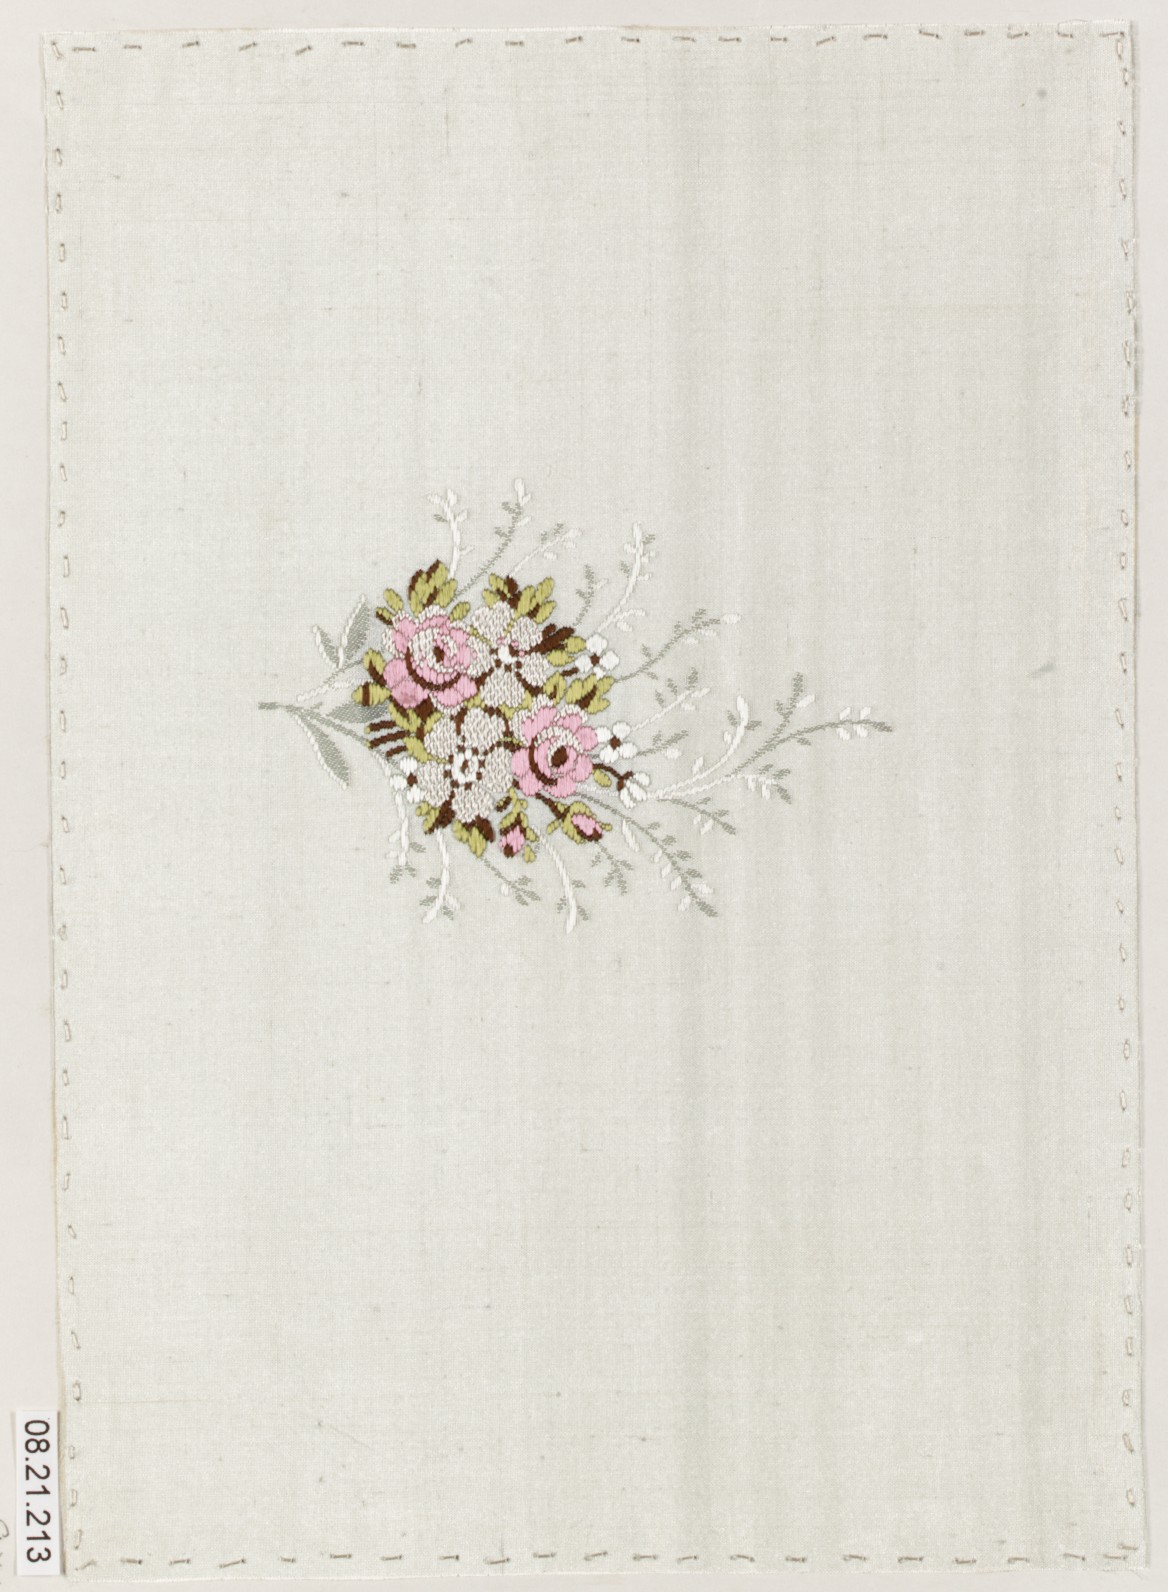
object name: textile sample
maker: Anonymous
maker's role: designer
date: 1900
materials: silk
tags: flowers